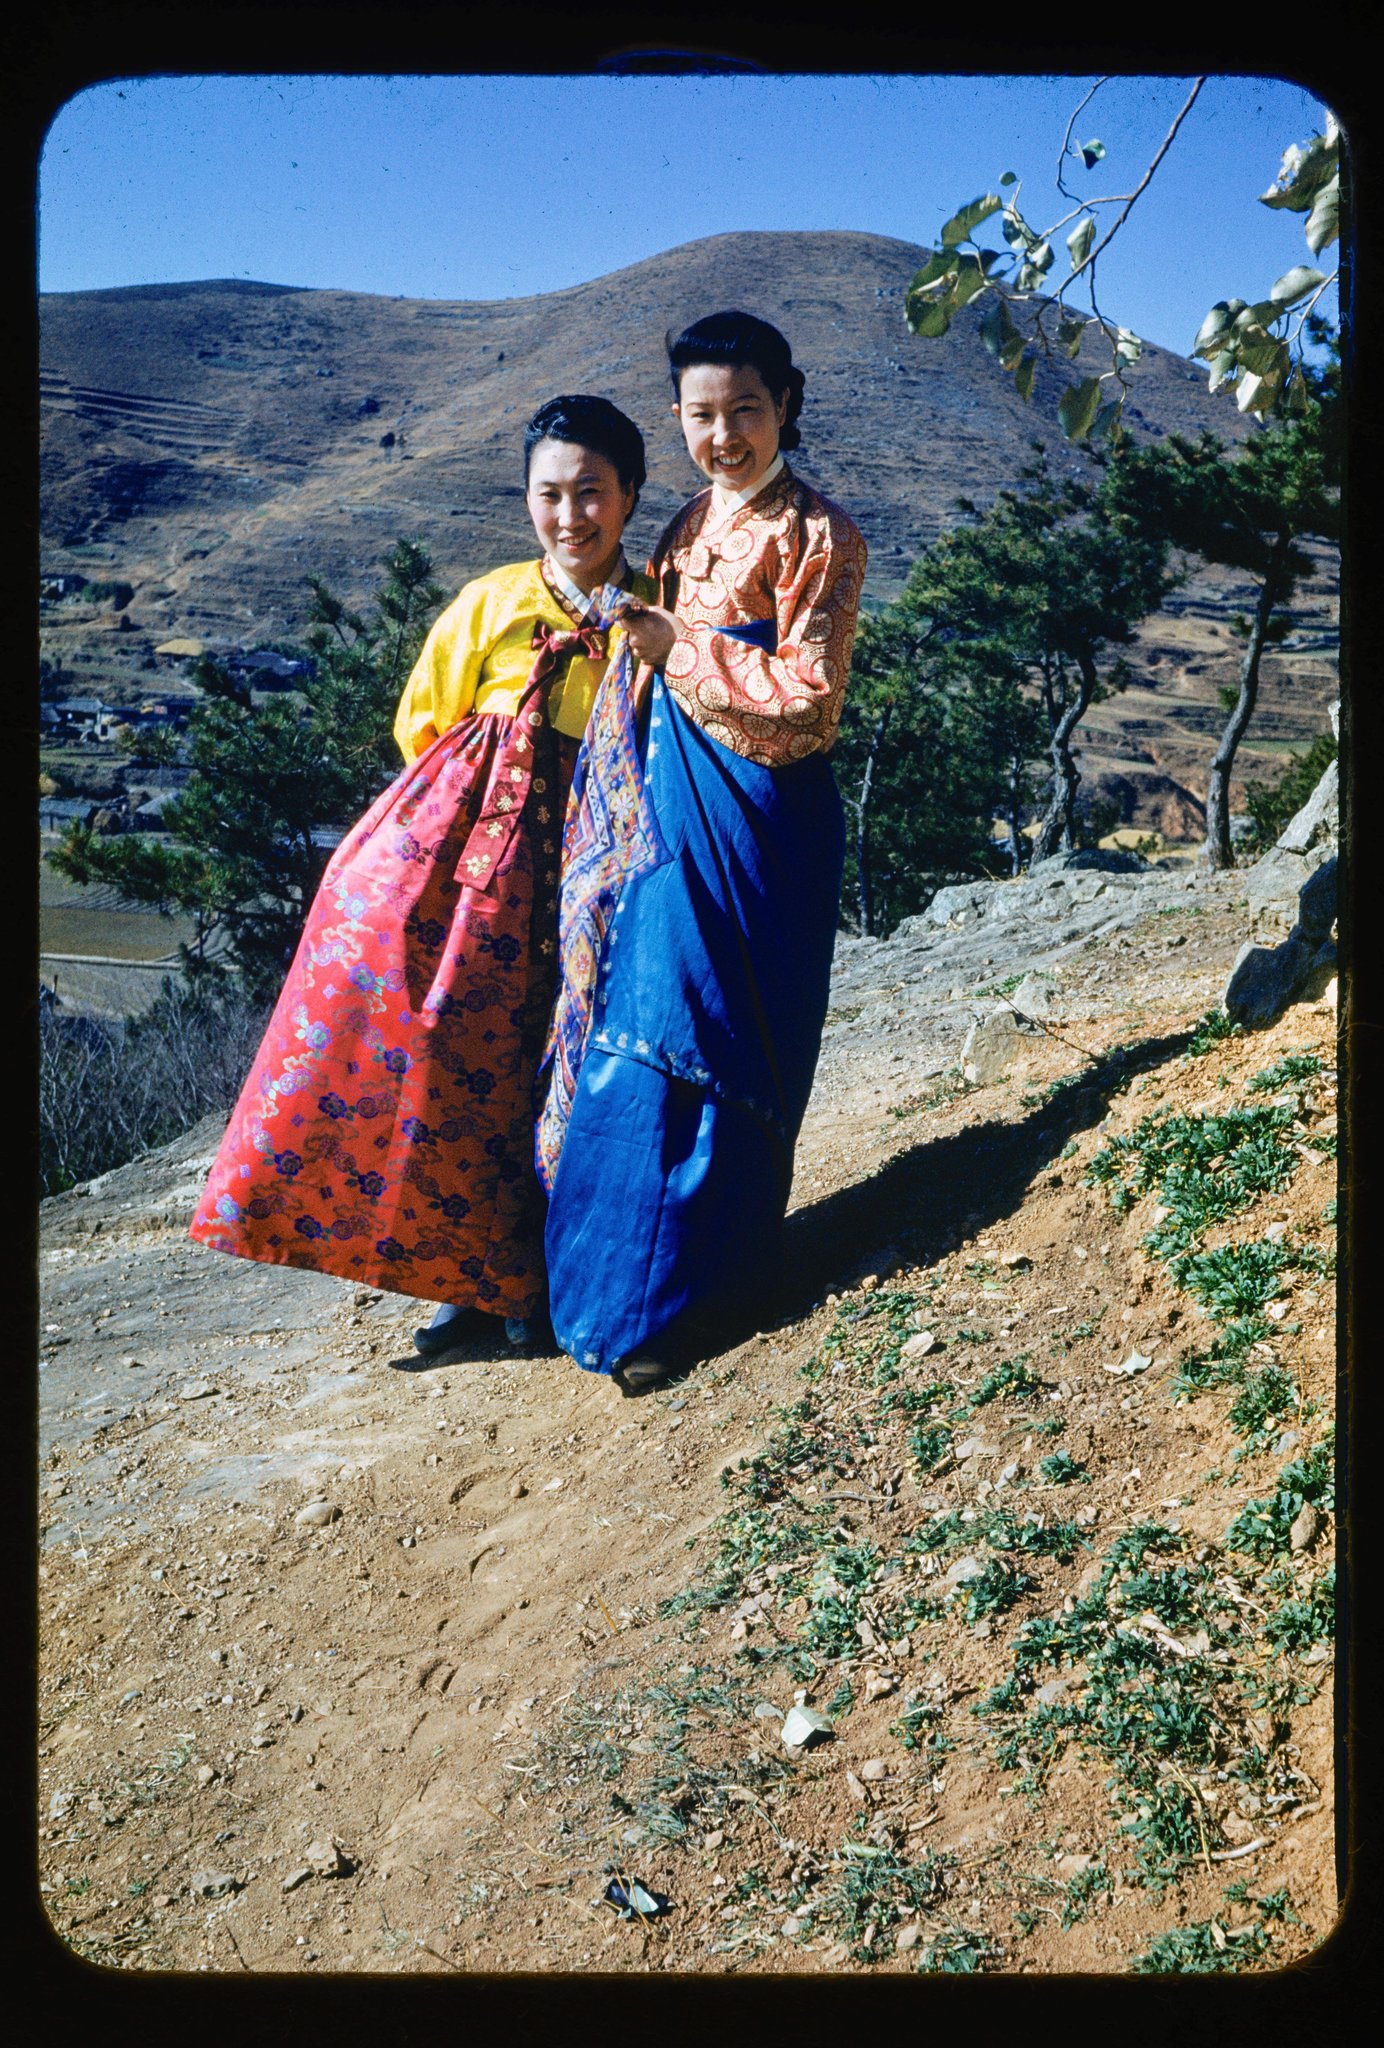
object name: color slide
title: Koreaanse vrouwen in nationaal kostuum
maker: david ketel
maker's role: diplomaat, sinoloog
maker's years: 1913-2008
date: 1950-1951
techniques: slide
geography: korea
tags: united nations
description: Koreaanse vrouwen uit de gegoede stand in een nationaal kostuum.